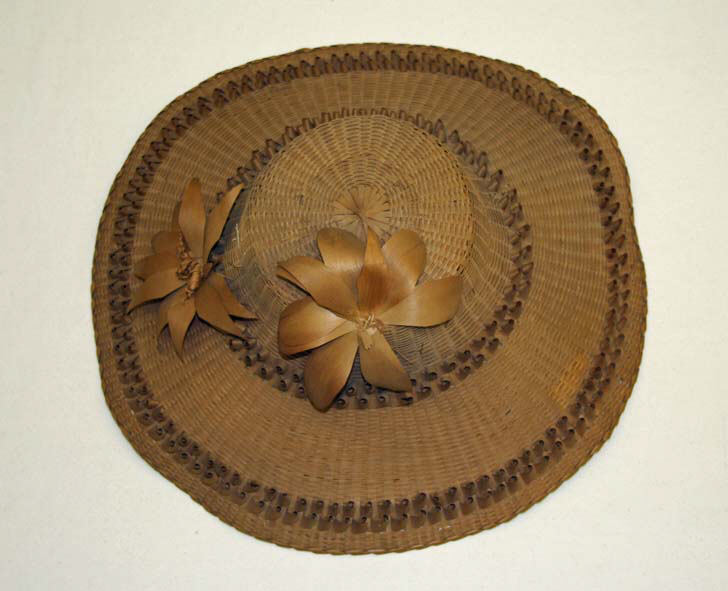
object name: hat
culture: american or european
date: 1860-1862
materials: silk, fiber, wood